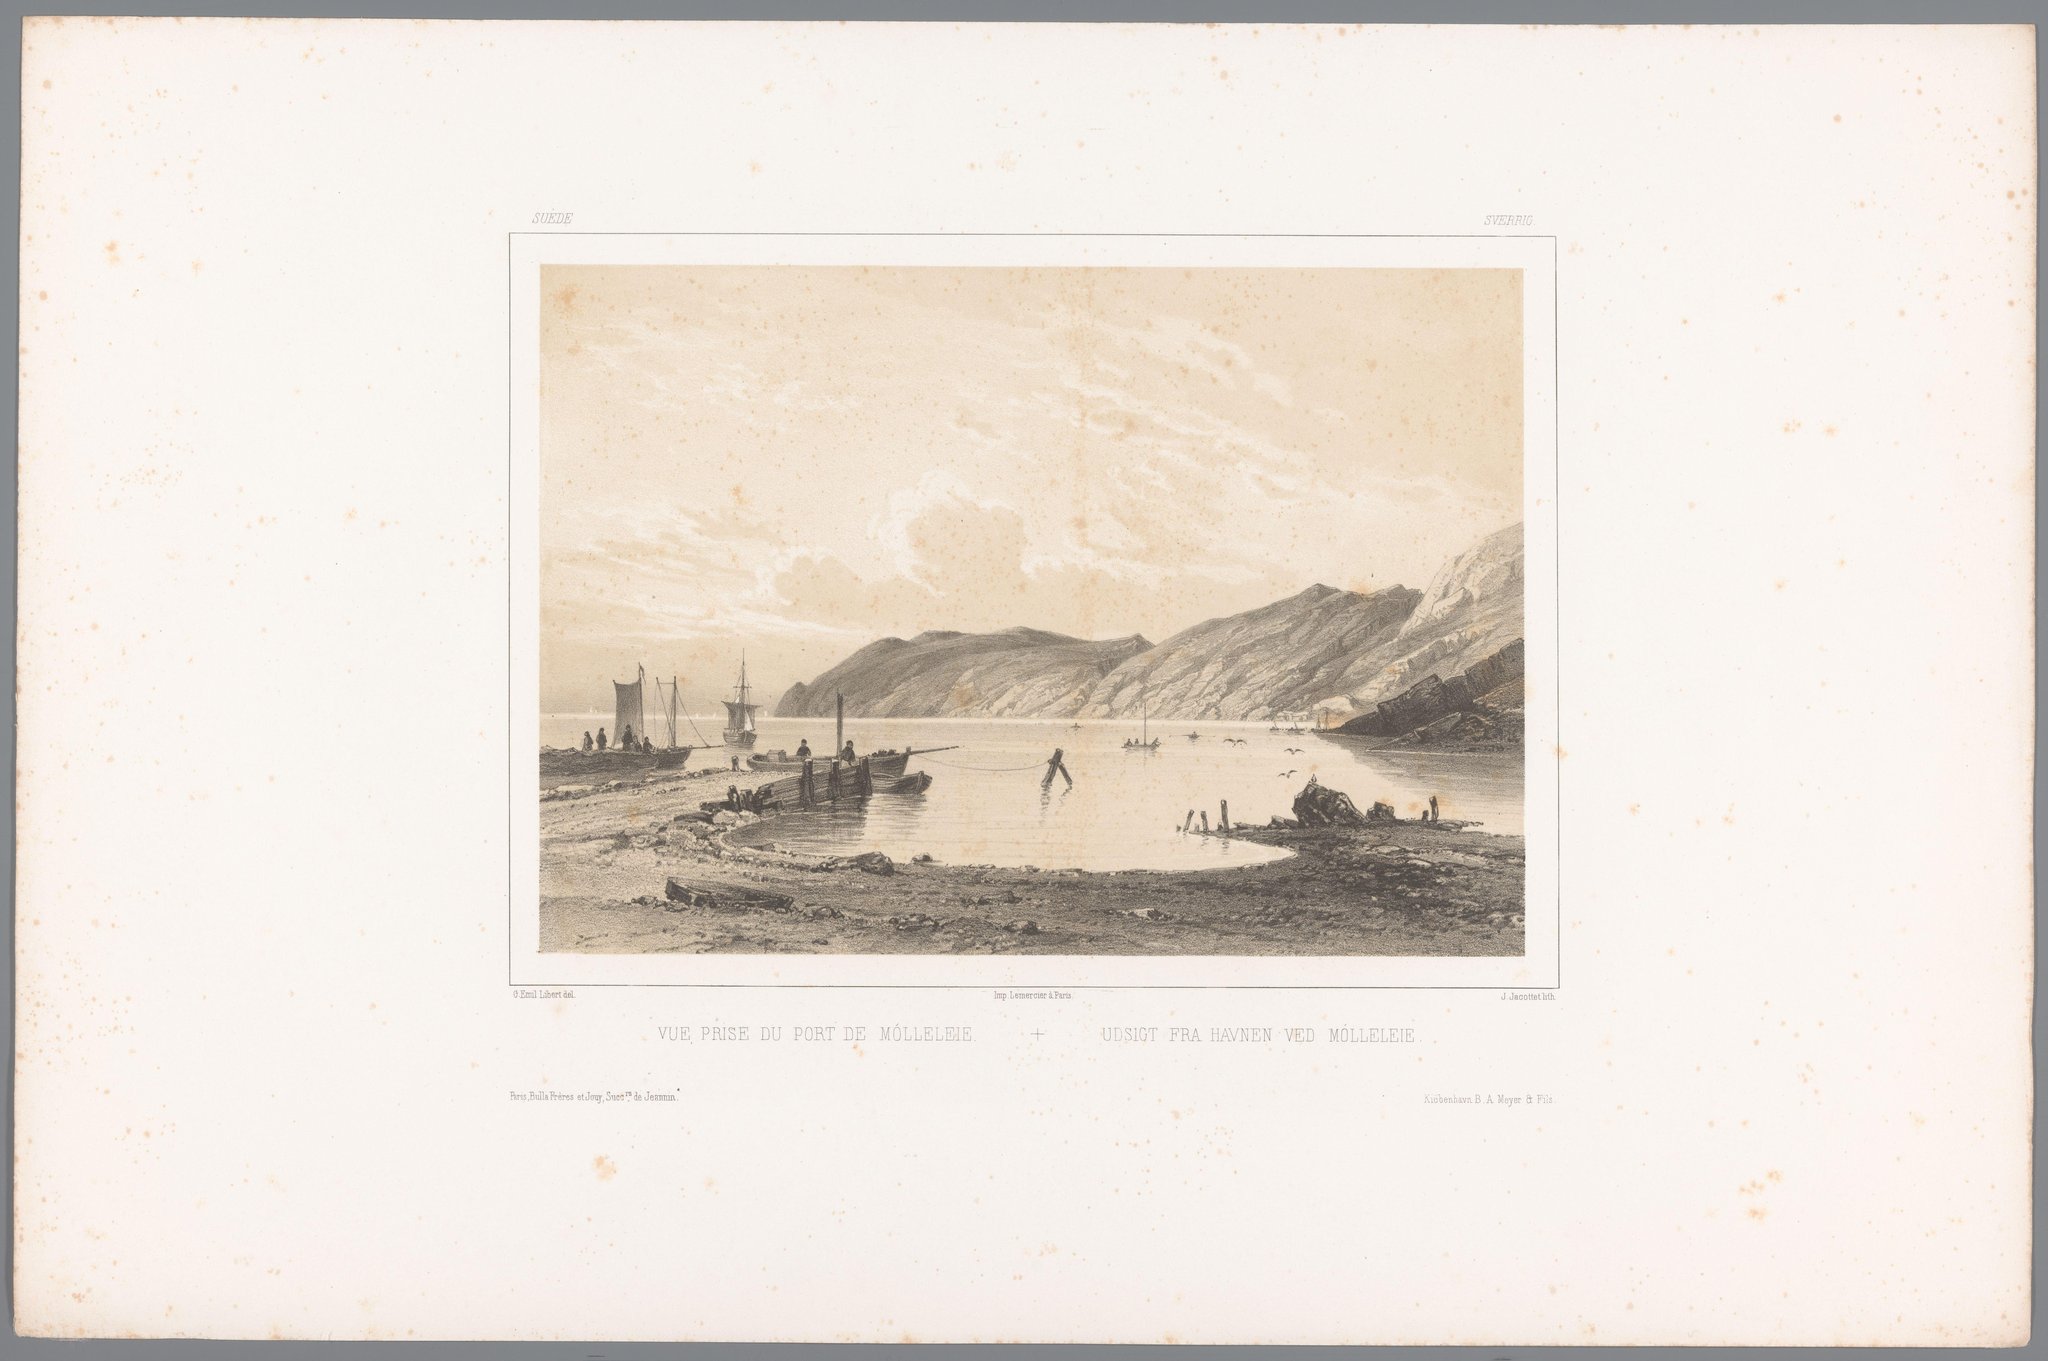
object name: print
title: Vues du Nord. Suède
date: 1851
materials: paper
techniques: tone lithography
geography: paris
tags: harbour, gulf, bay (+ landscape with figures, staffage), mountains (+ landscape with figures, staffage)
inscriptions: collector's mark: Lugt 2228a